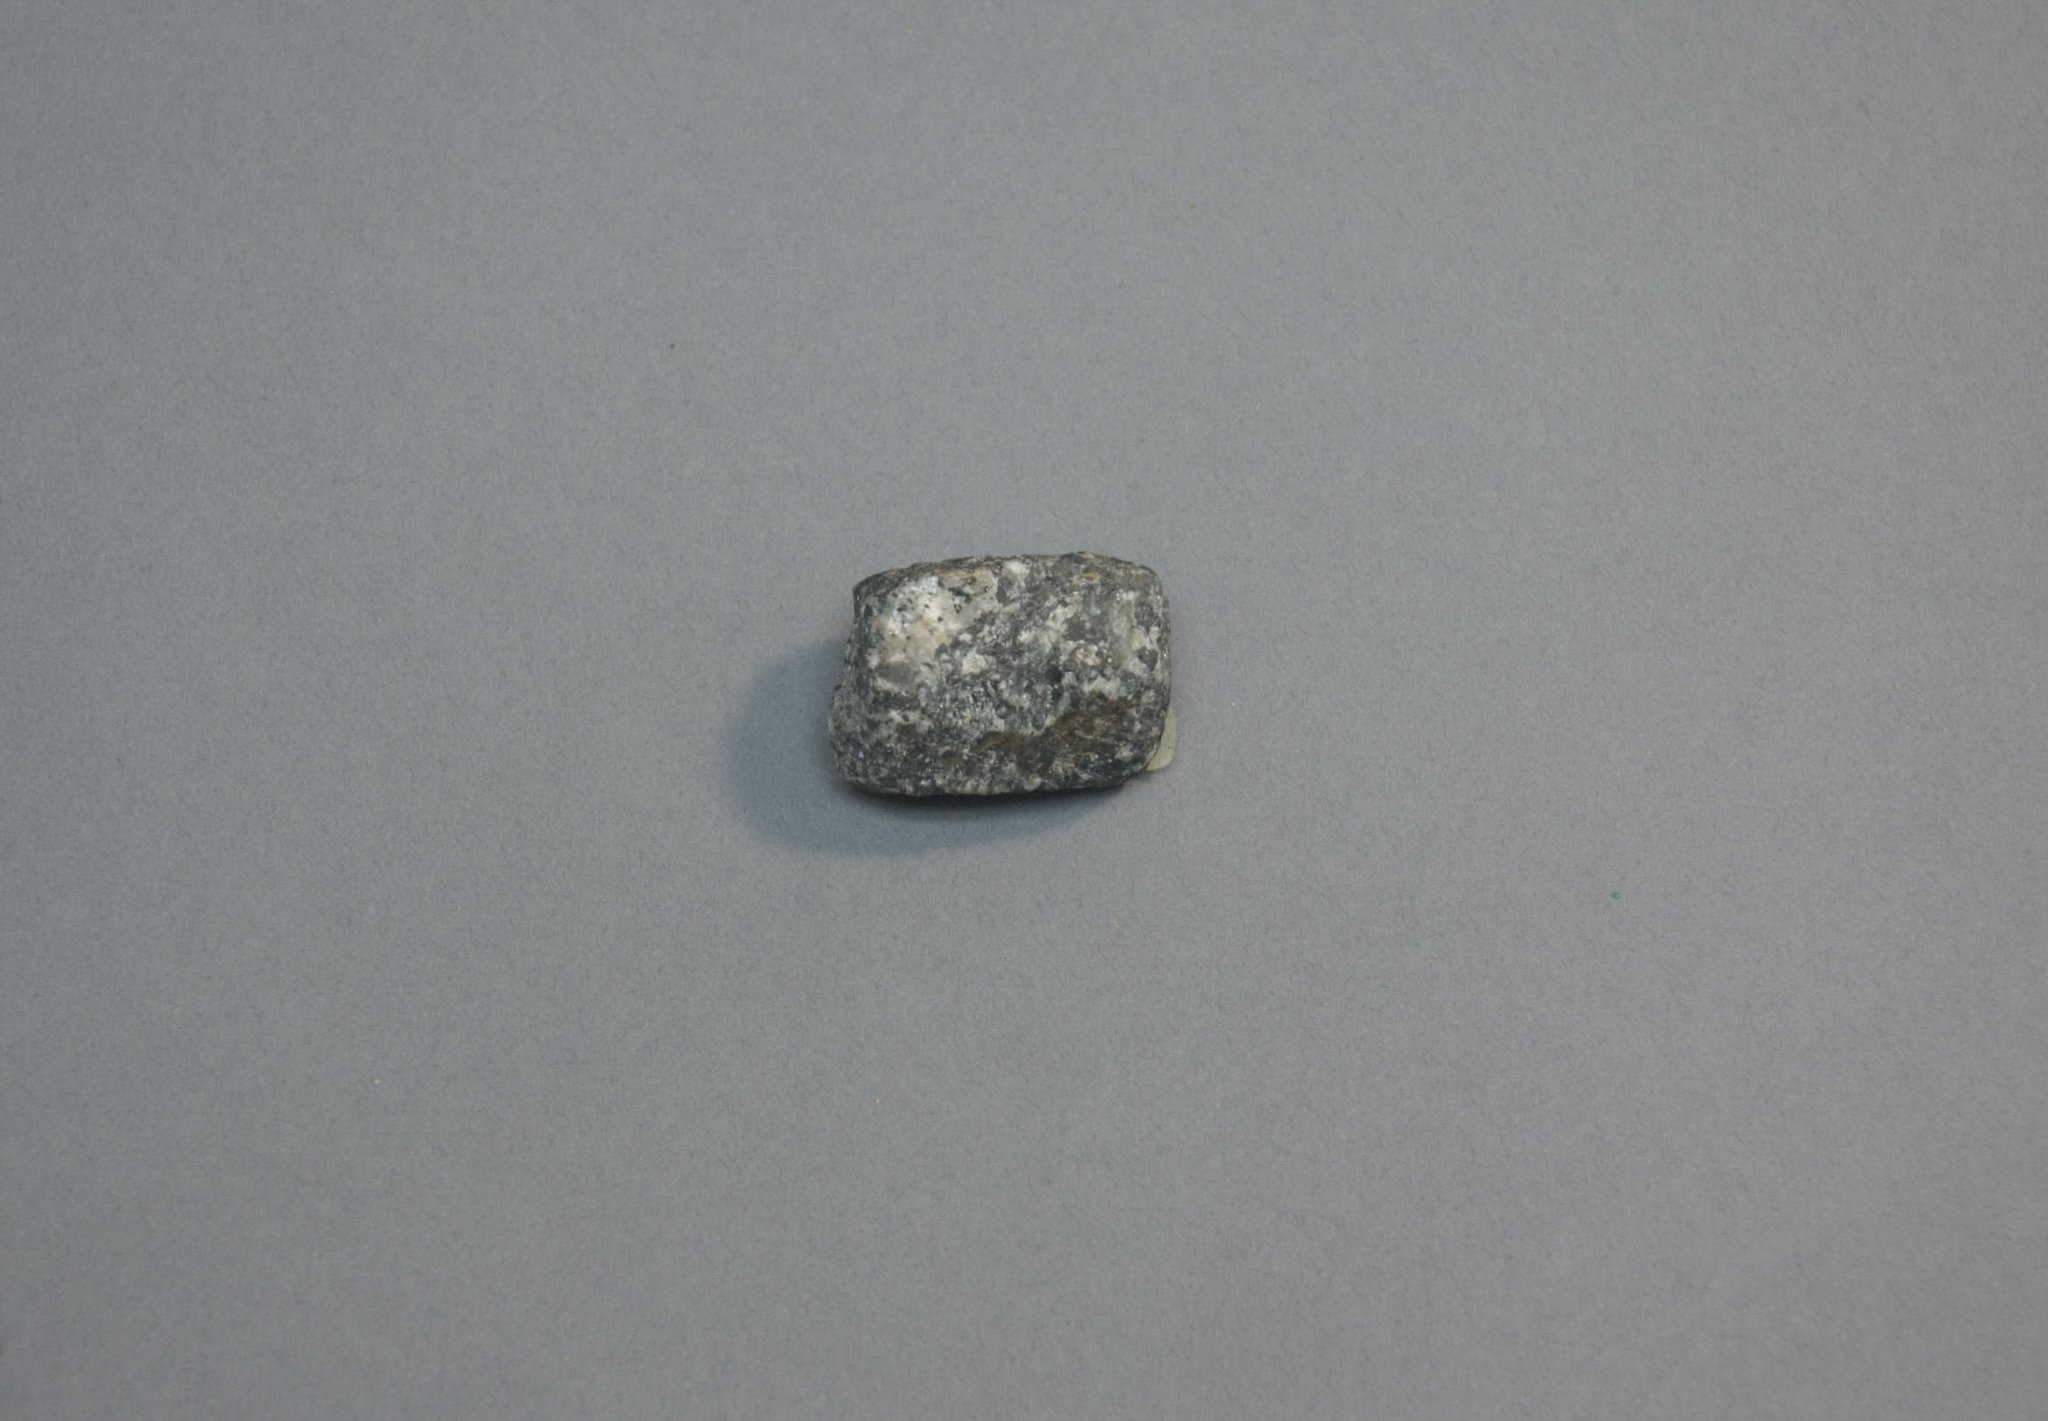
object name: jade carving material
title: Piece of Corundum Crystal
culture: chinese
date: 1901-2000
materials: crystal